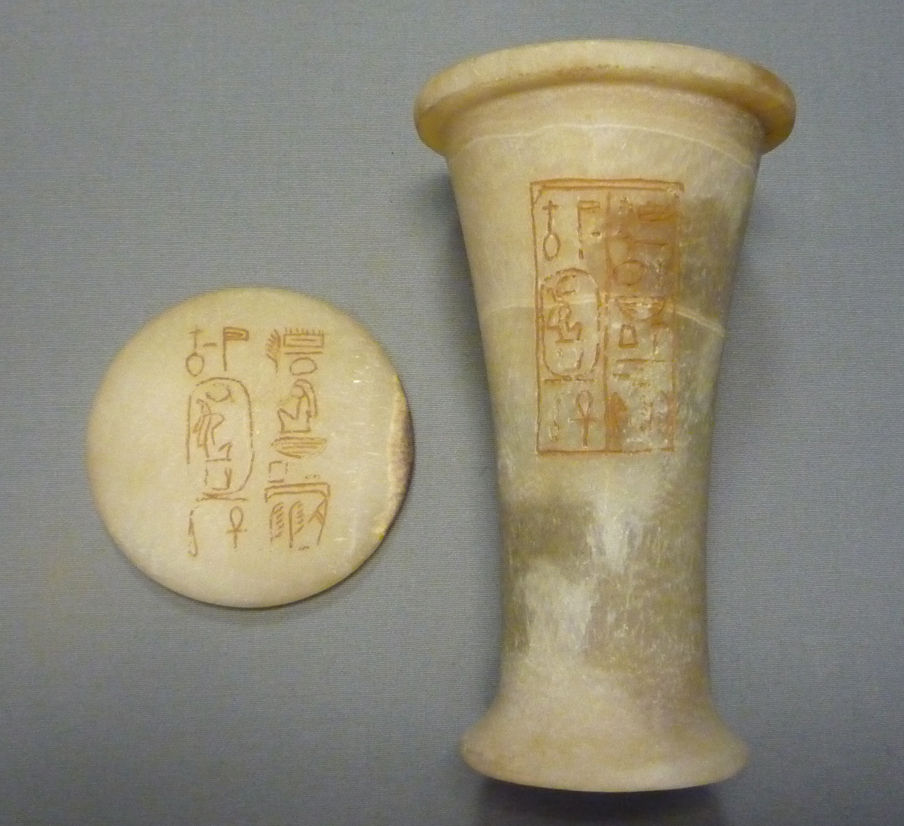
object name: ointment jar, foundation deposit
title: Ointment Jar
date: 1479-1458 BCE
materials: stone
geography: egypt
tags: hieroglyphs